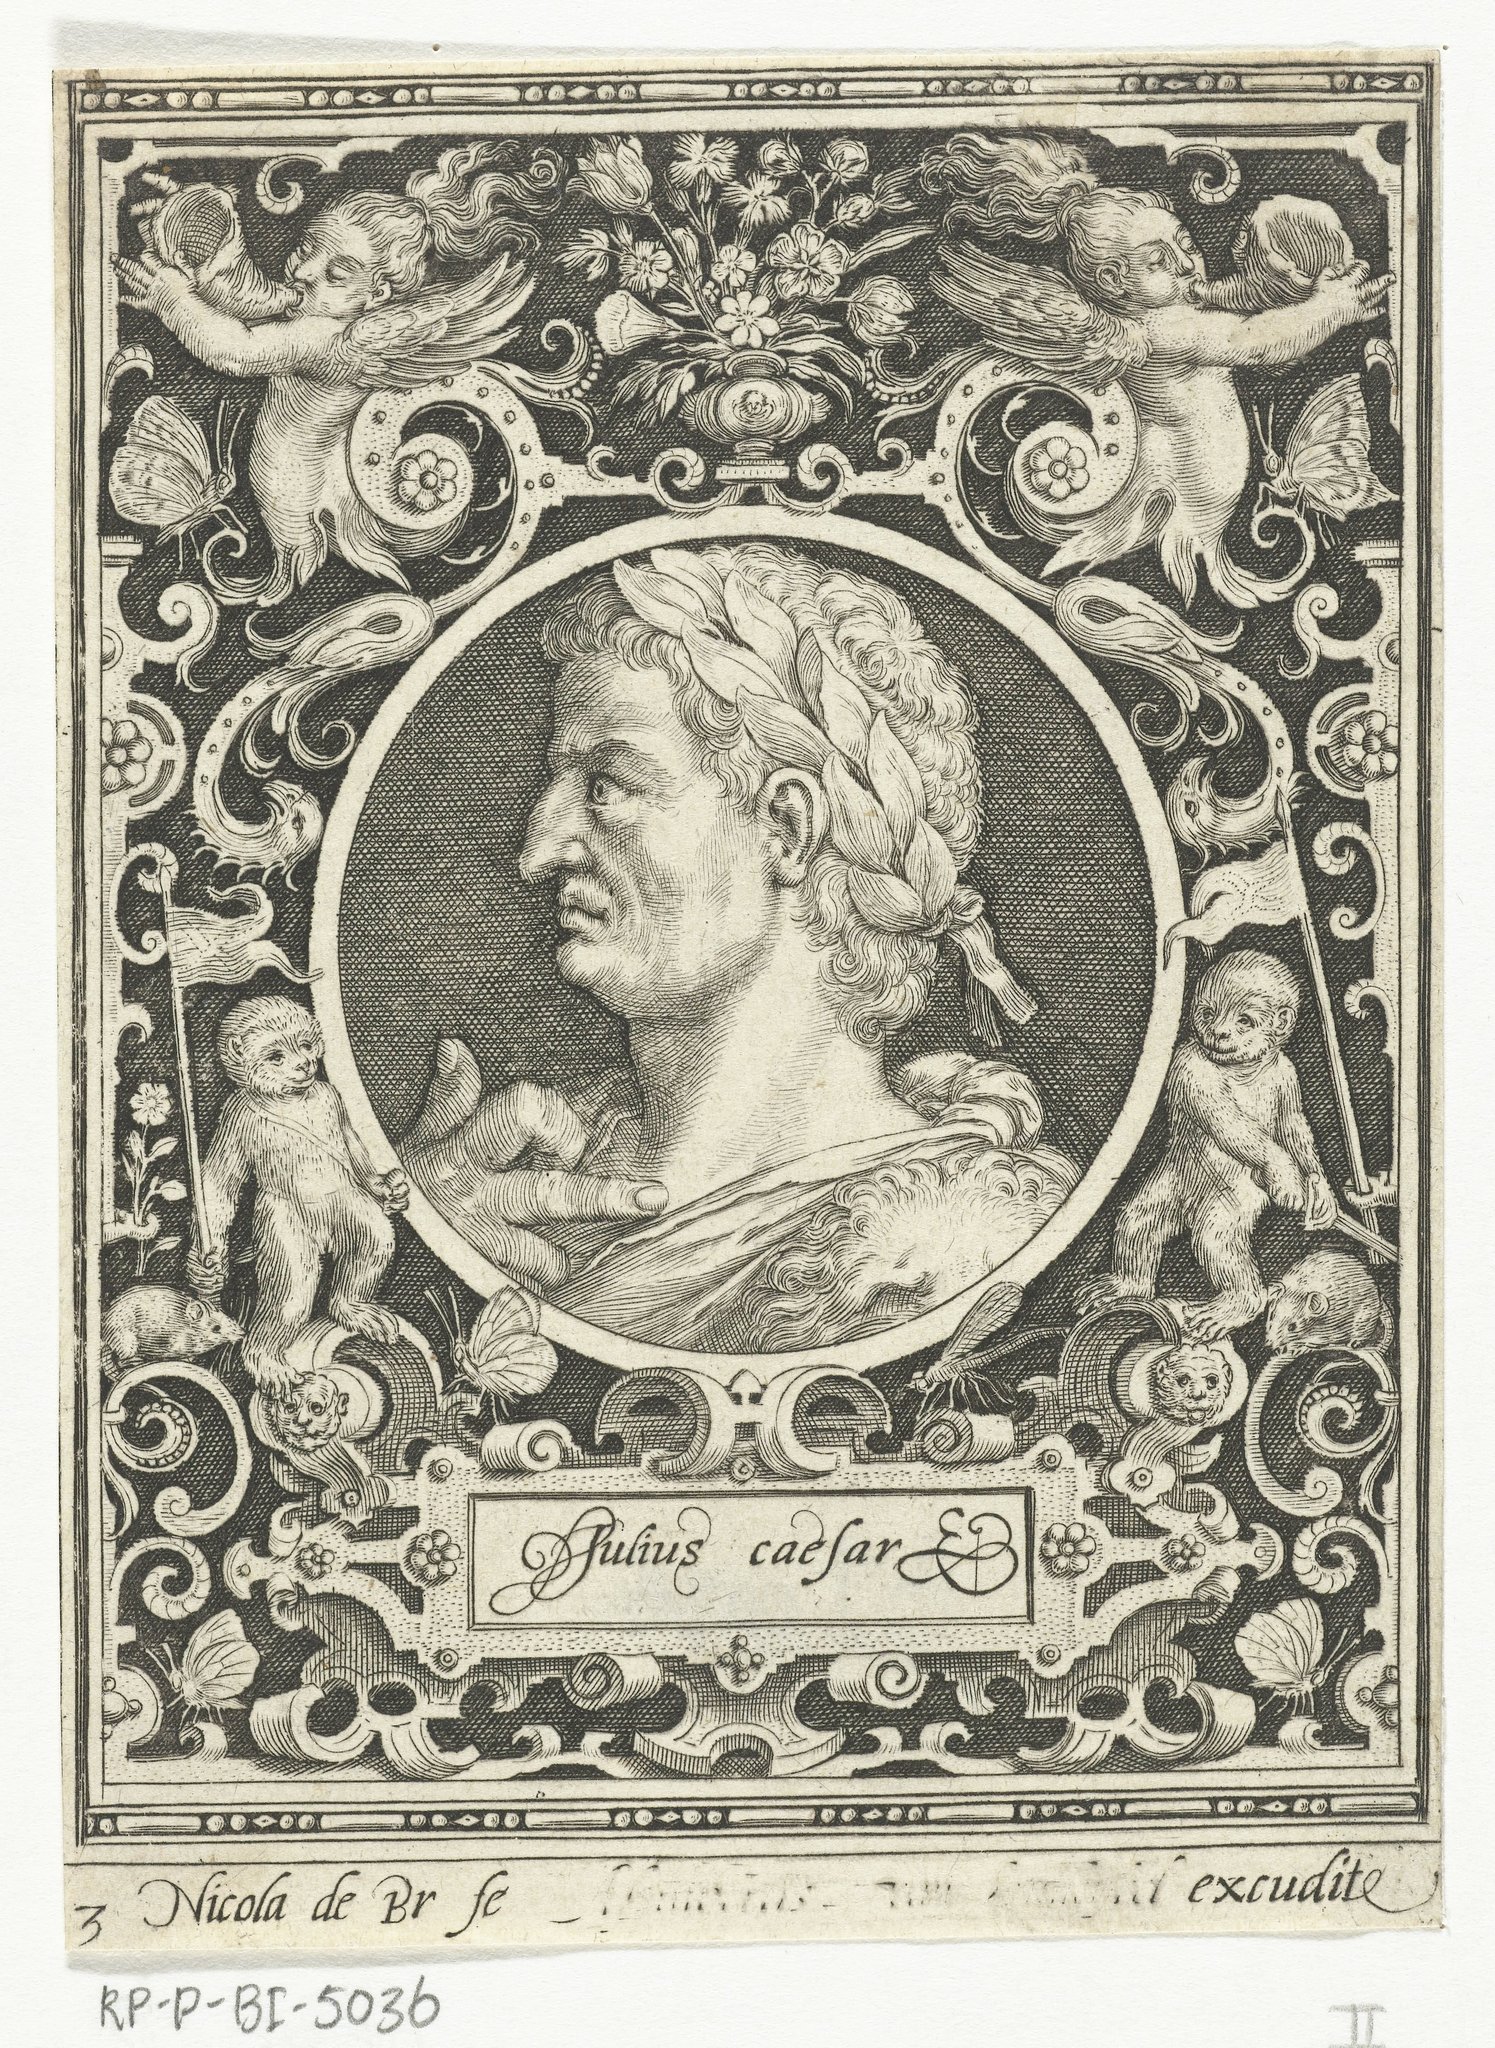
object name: print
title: De negen besten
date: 1594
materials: paper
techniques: engraving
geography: netherlands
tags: rome, julius caesar (one of the nine worthies)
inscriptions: collector's mark: Lugt 2228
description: Prent uit serie van negen prenten met de negen besten. In de marge onder is met moeite de op de drukplaat verwijderde naam van uitgever Assuerus van Londerseel nog leesbaar.